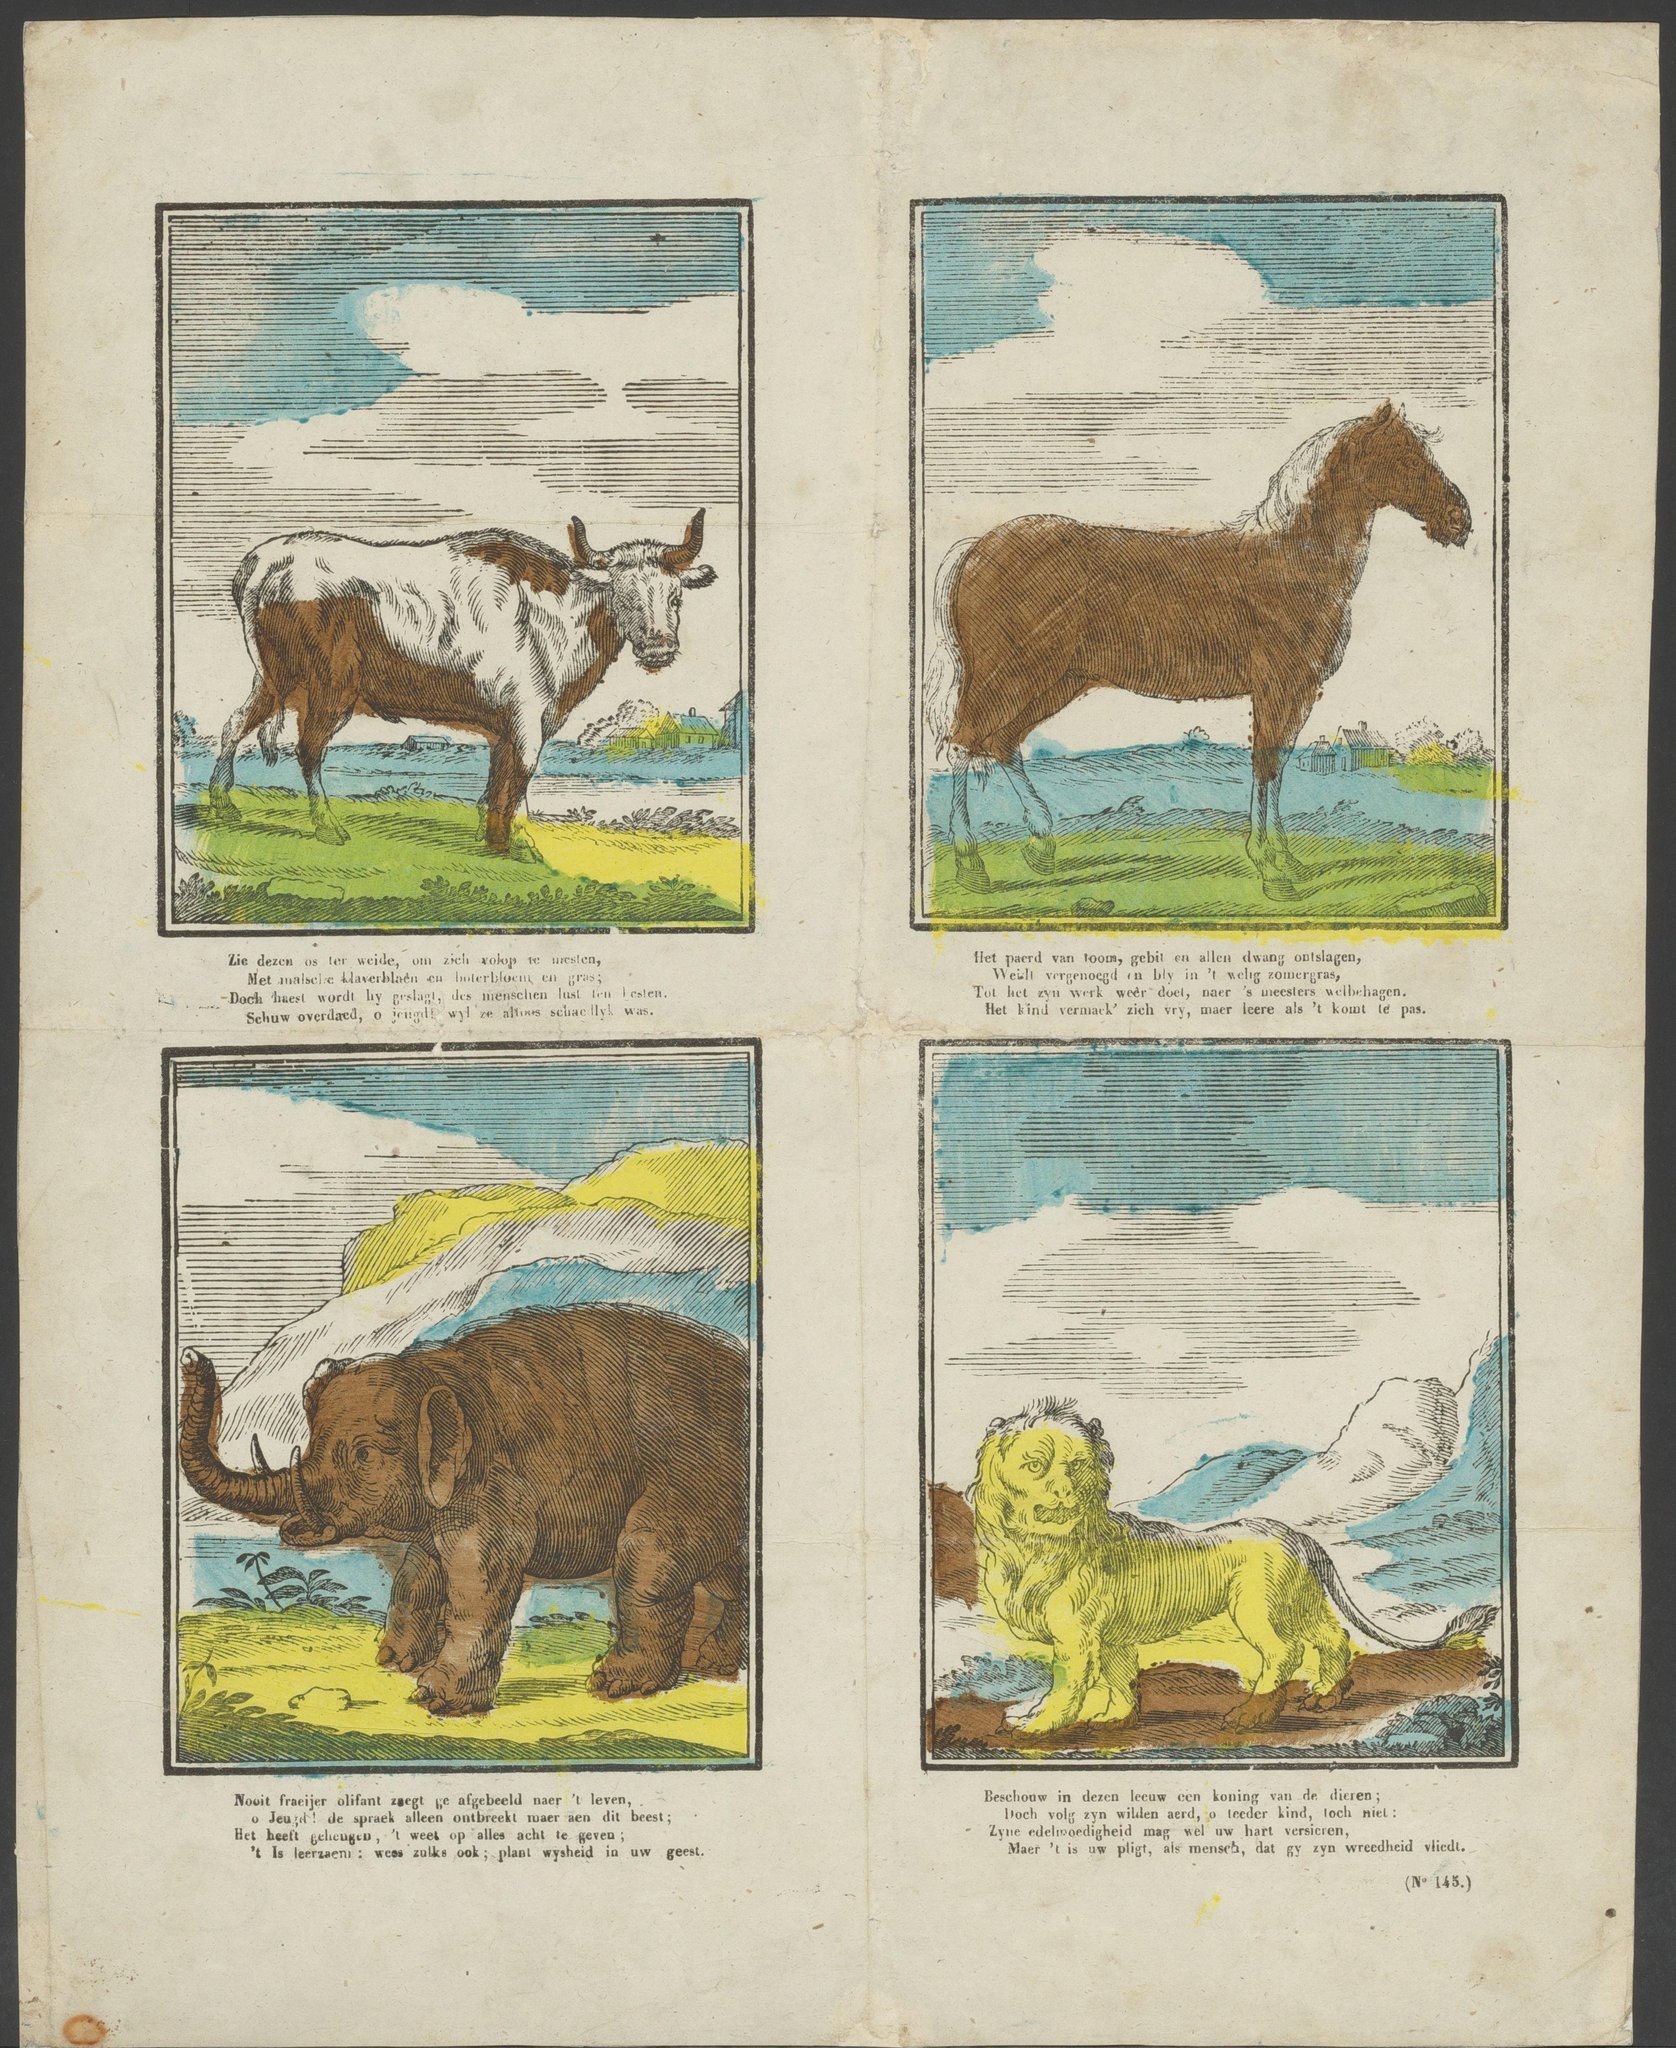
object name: popular print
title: Os, paard, olifant en leeuw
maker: hendrik numan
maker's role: draughtsman, print maker, publisher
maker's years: 1736-1788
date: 1833-1856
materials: paper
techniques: hand coloring, letterpress printing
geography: turnhout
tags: horse, ox, beasts of prey, predatory animals: lion, trunked animals: elephant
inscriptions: collector's mark: Lugt 1641, stamp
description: Rechtsonder genummerd: (No 145.). Onderwerpsrubrieken binnen de Atlas Zeden en Gewoonten: Zeden en Gewoonten in Engeren Zin, Des menschen beging, midden en einde, Kinderleven – Kinderspel en Kinderprenten.